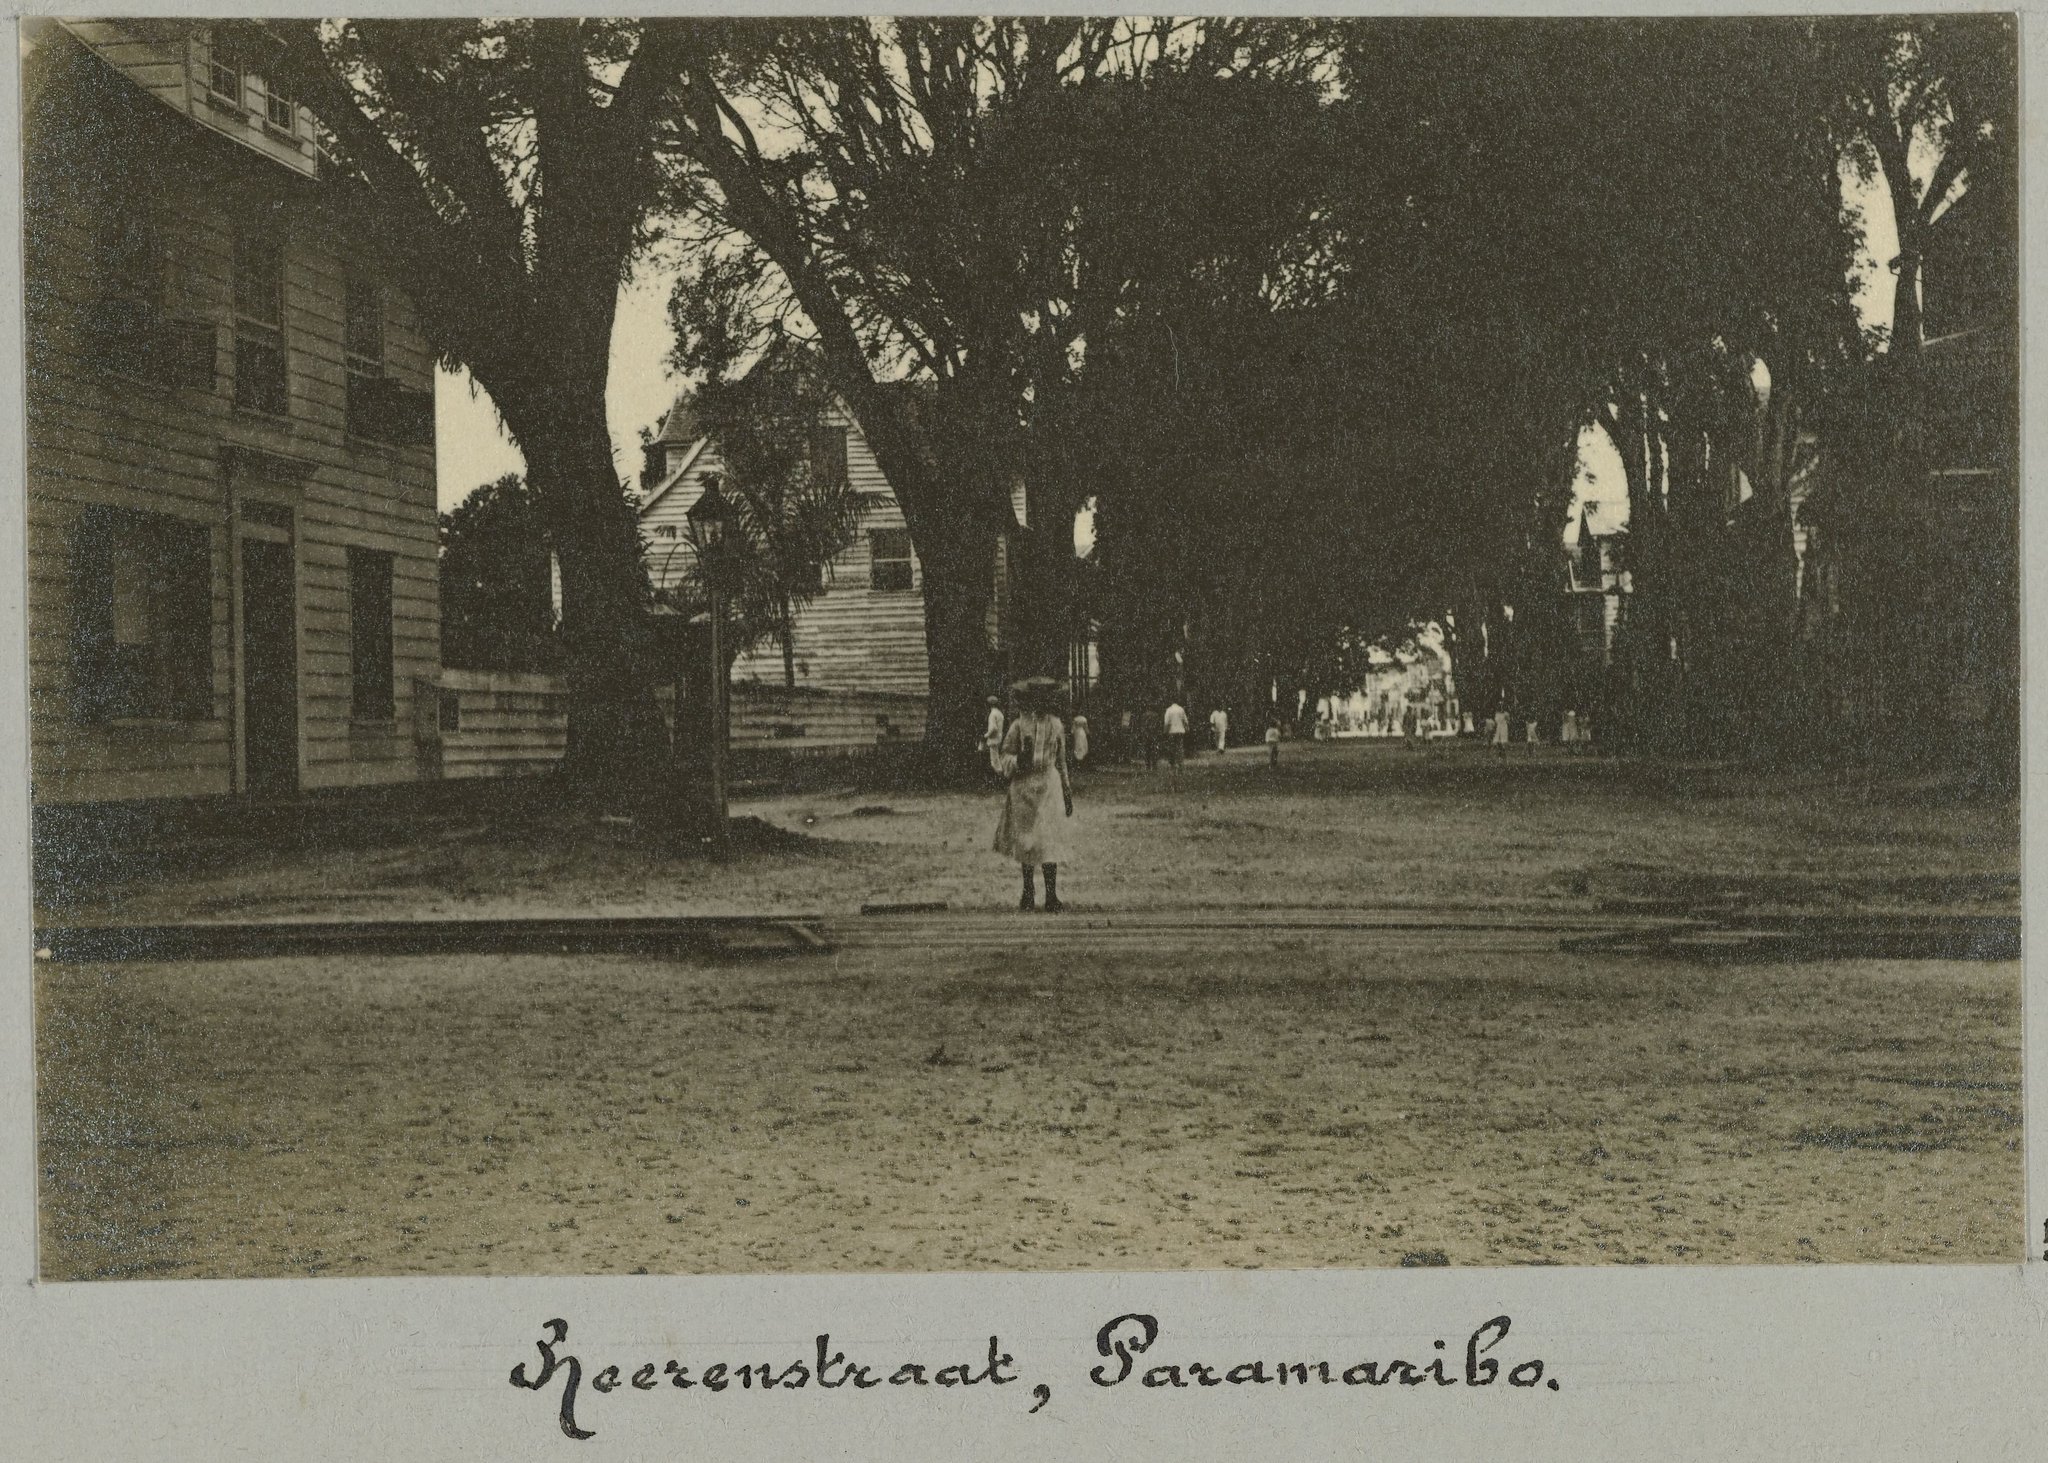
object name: photograph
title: Heerenstraat, Paramaribo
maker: hendrik doijer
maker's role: engineer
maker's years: 1863-1925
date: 1903-1910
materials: photographic support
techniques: gelatin silver print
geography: suriname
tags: suriname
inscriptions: inscription: ‘59. / Heerenstraat, Paramaribo’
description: Een vrouw lopend door de Heerenstraat te Paramaribo. Onderdeel van het fotoalbum Souvenir de Voyage (deel 2), over het leven van de familie Doijer in en rond de plantage Ma Retraite in Suriname in de jaren 1903-1910.